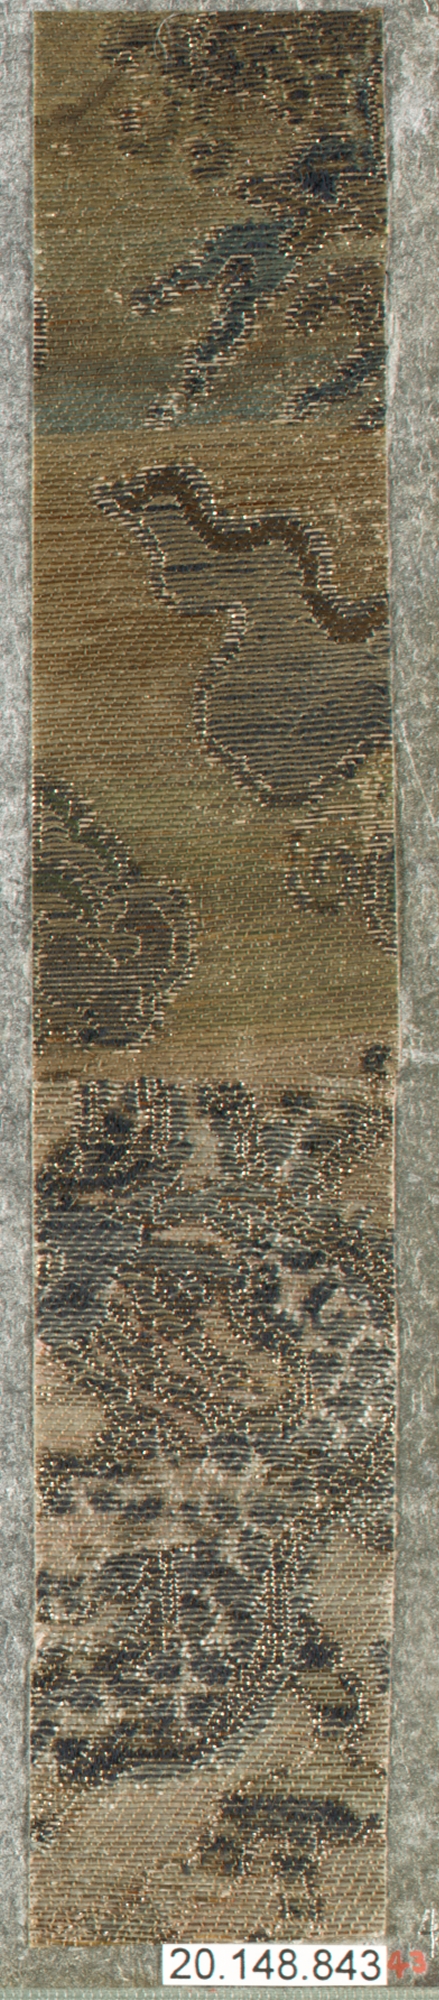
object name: piece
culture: japanese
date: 1601-1700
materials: silk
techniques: compound weave